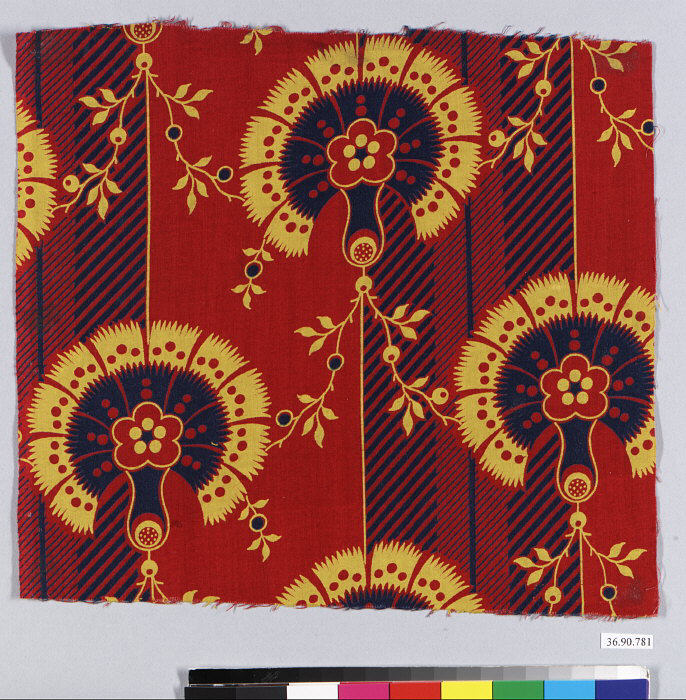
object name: piece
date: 1867-1900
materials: cotton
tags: flowers,leaves